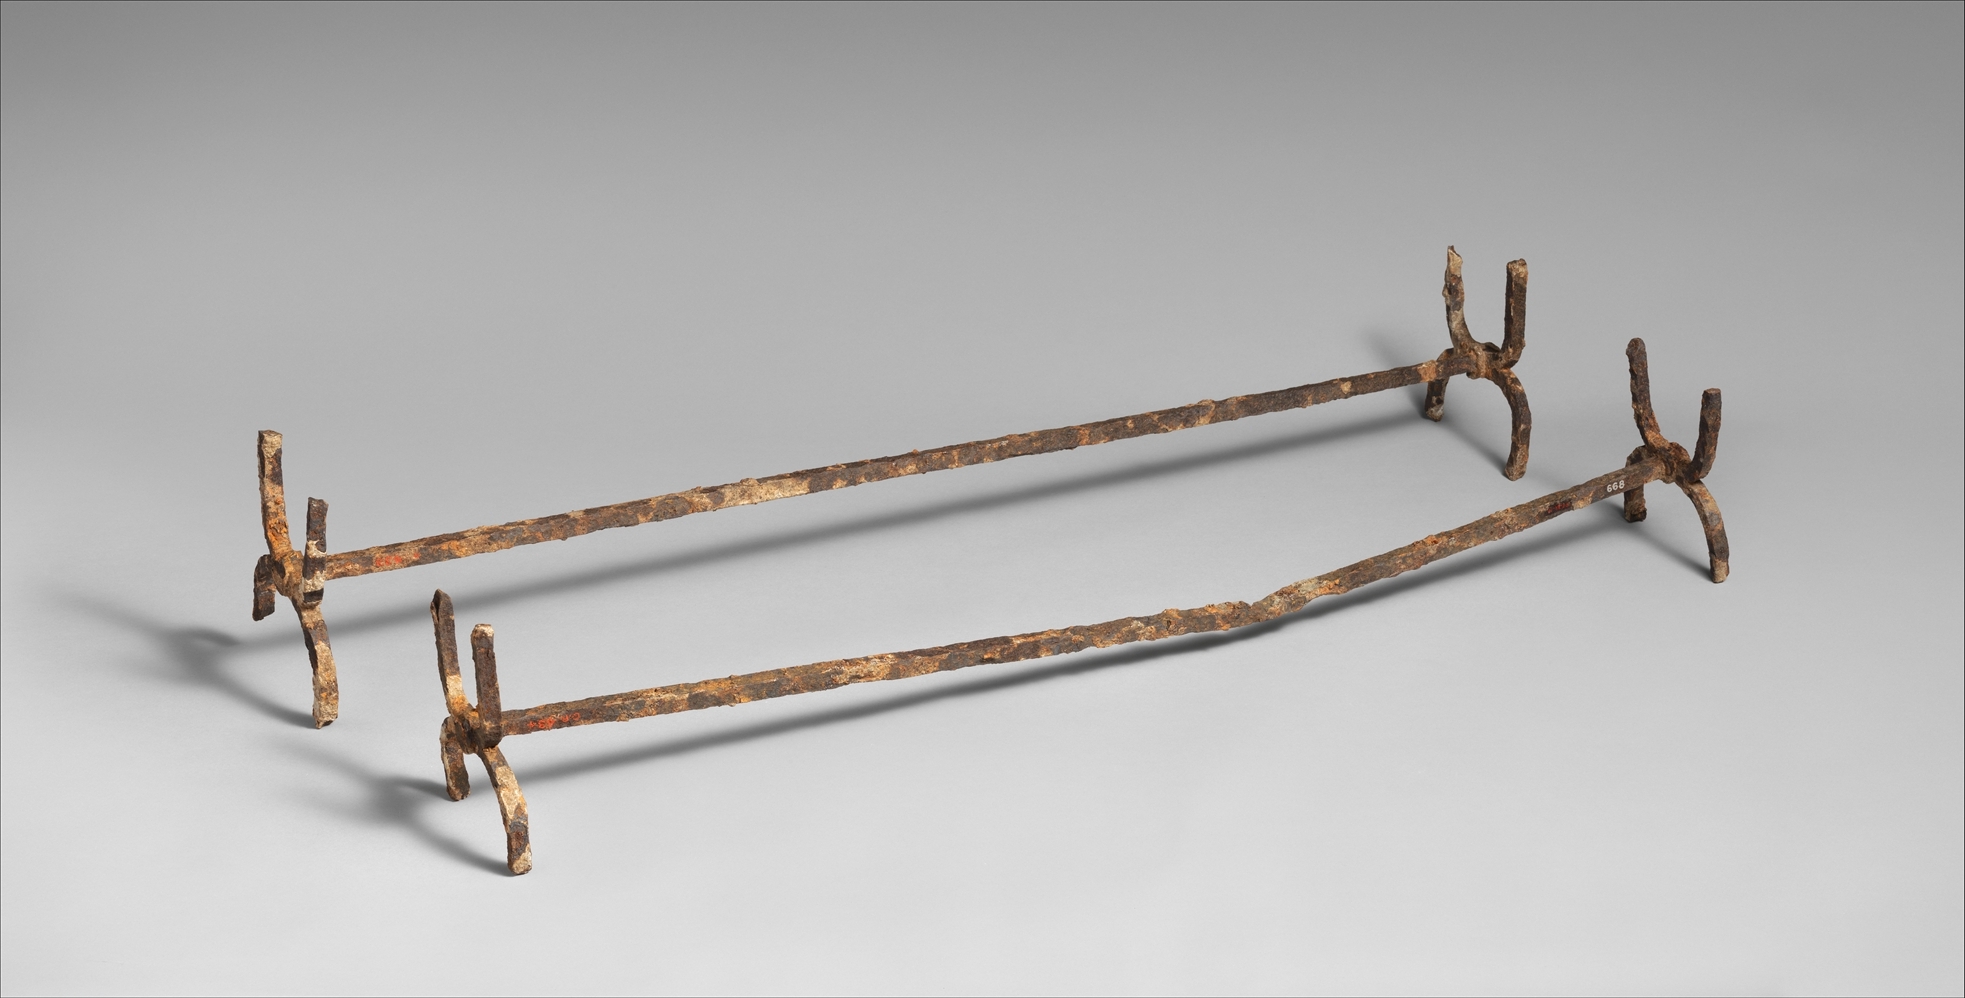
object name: fire dog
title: Iron fire-dog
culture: etruscan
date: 550 BCE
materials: iron